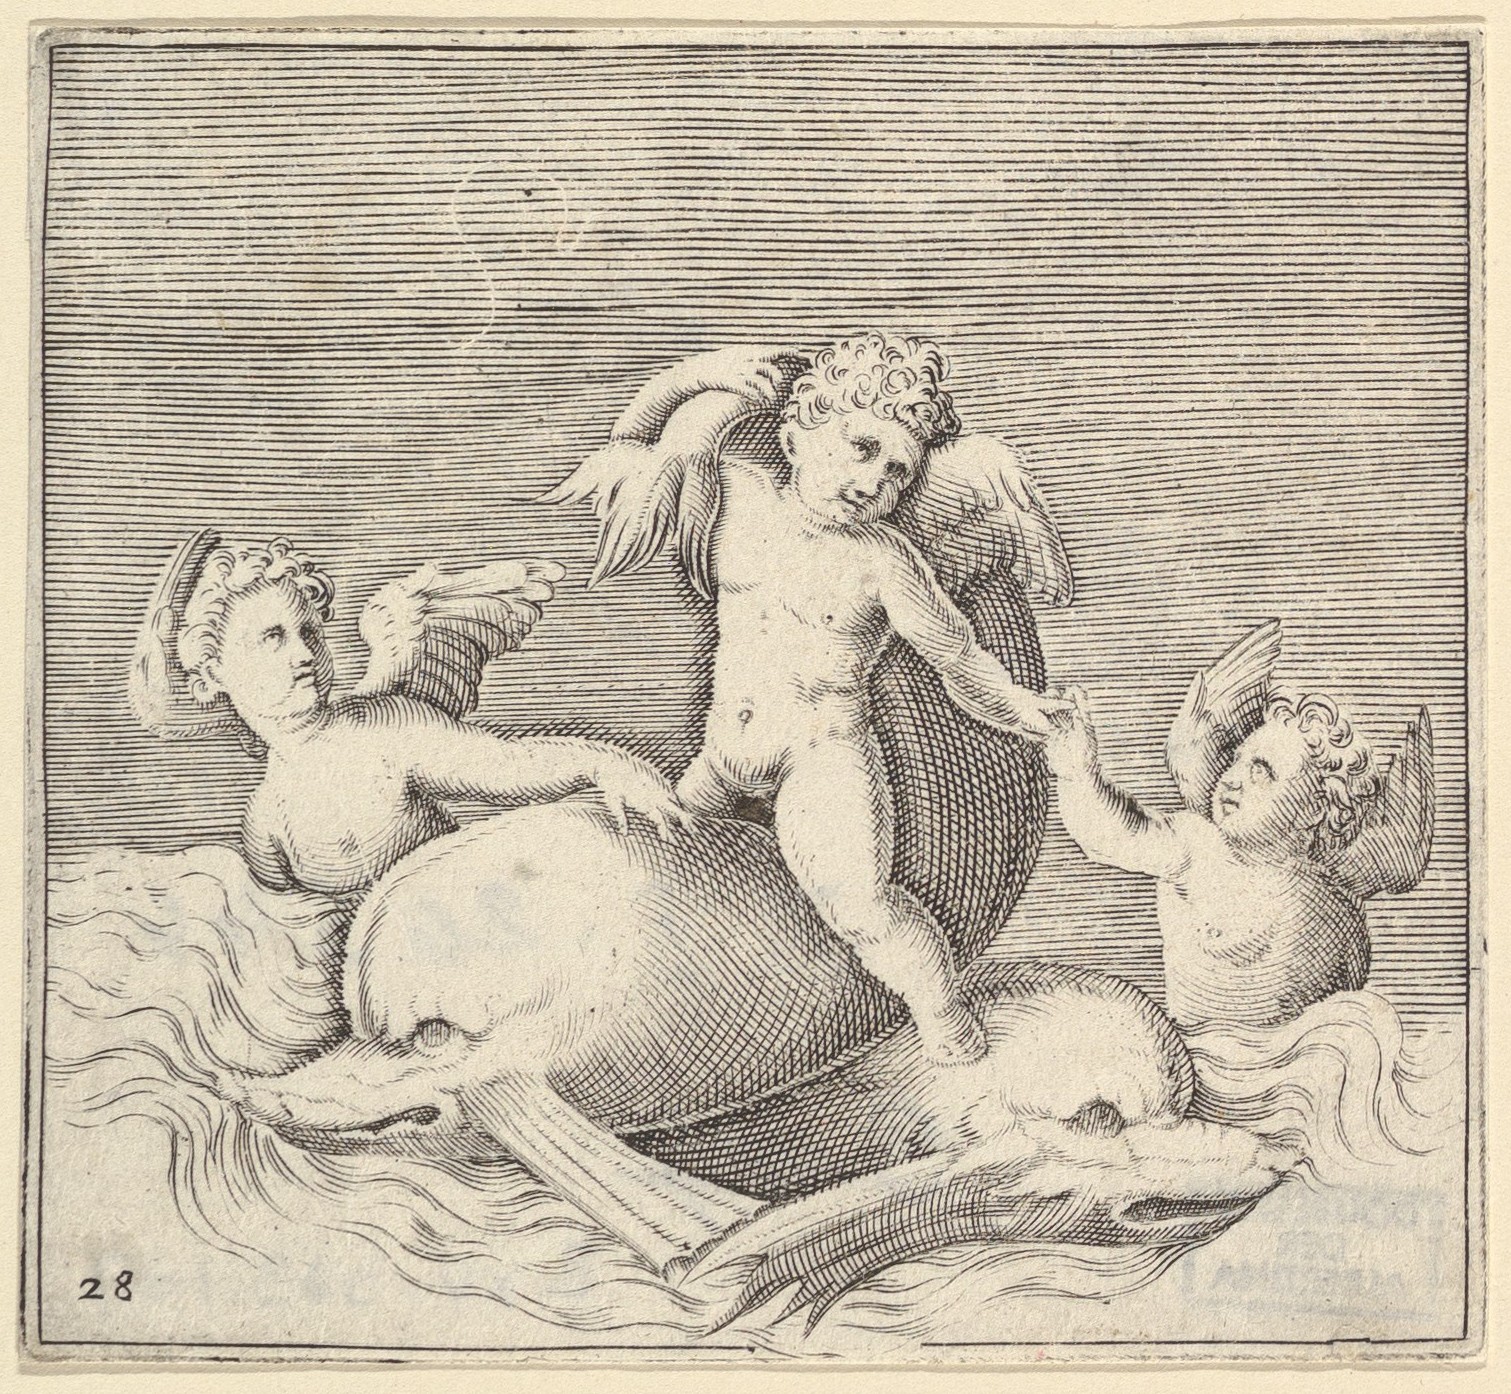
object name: print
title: Three Cupids and Two Dolphins, from "Ex Antiquis Cameorum et Gemmae Delineata/ Liber Secundus/et ab Enea Vico Parmen Incis"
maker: anonymous, italian, 16th century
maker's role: artist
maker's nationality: italian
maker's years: 1500-1600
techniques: engraving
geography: rome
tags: cupid,dolphins